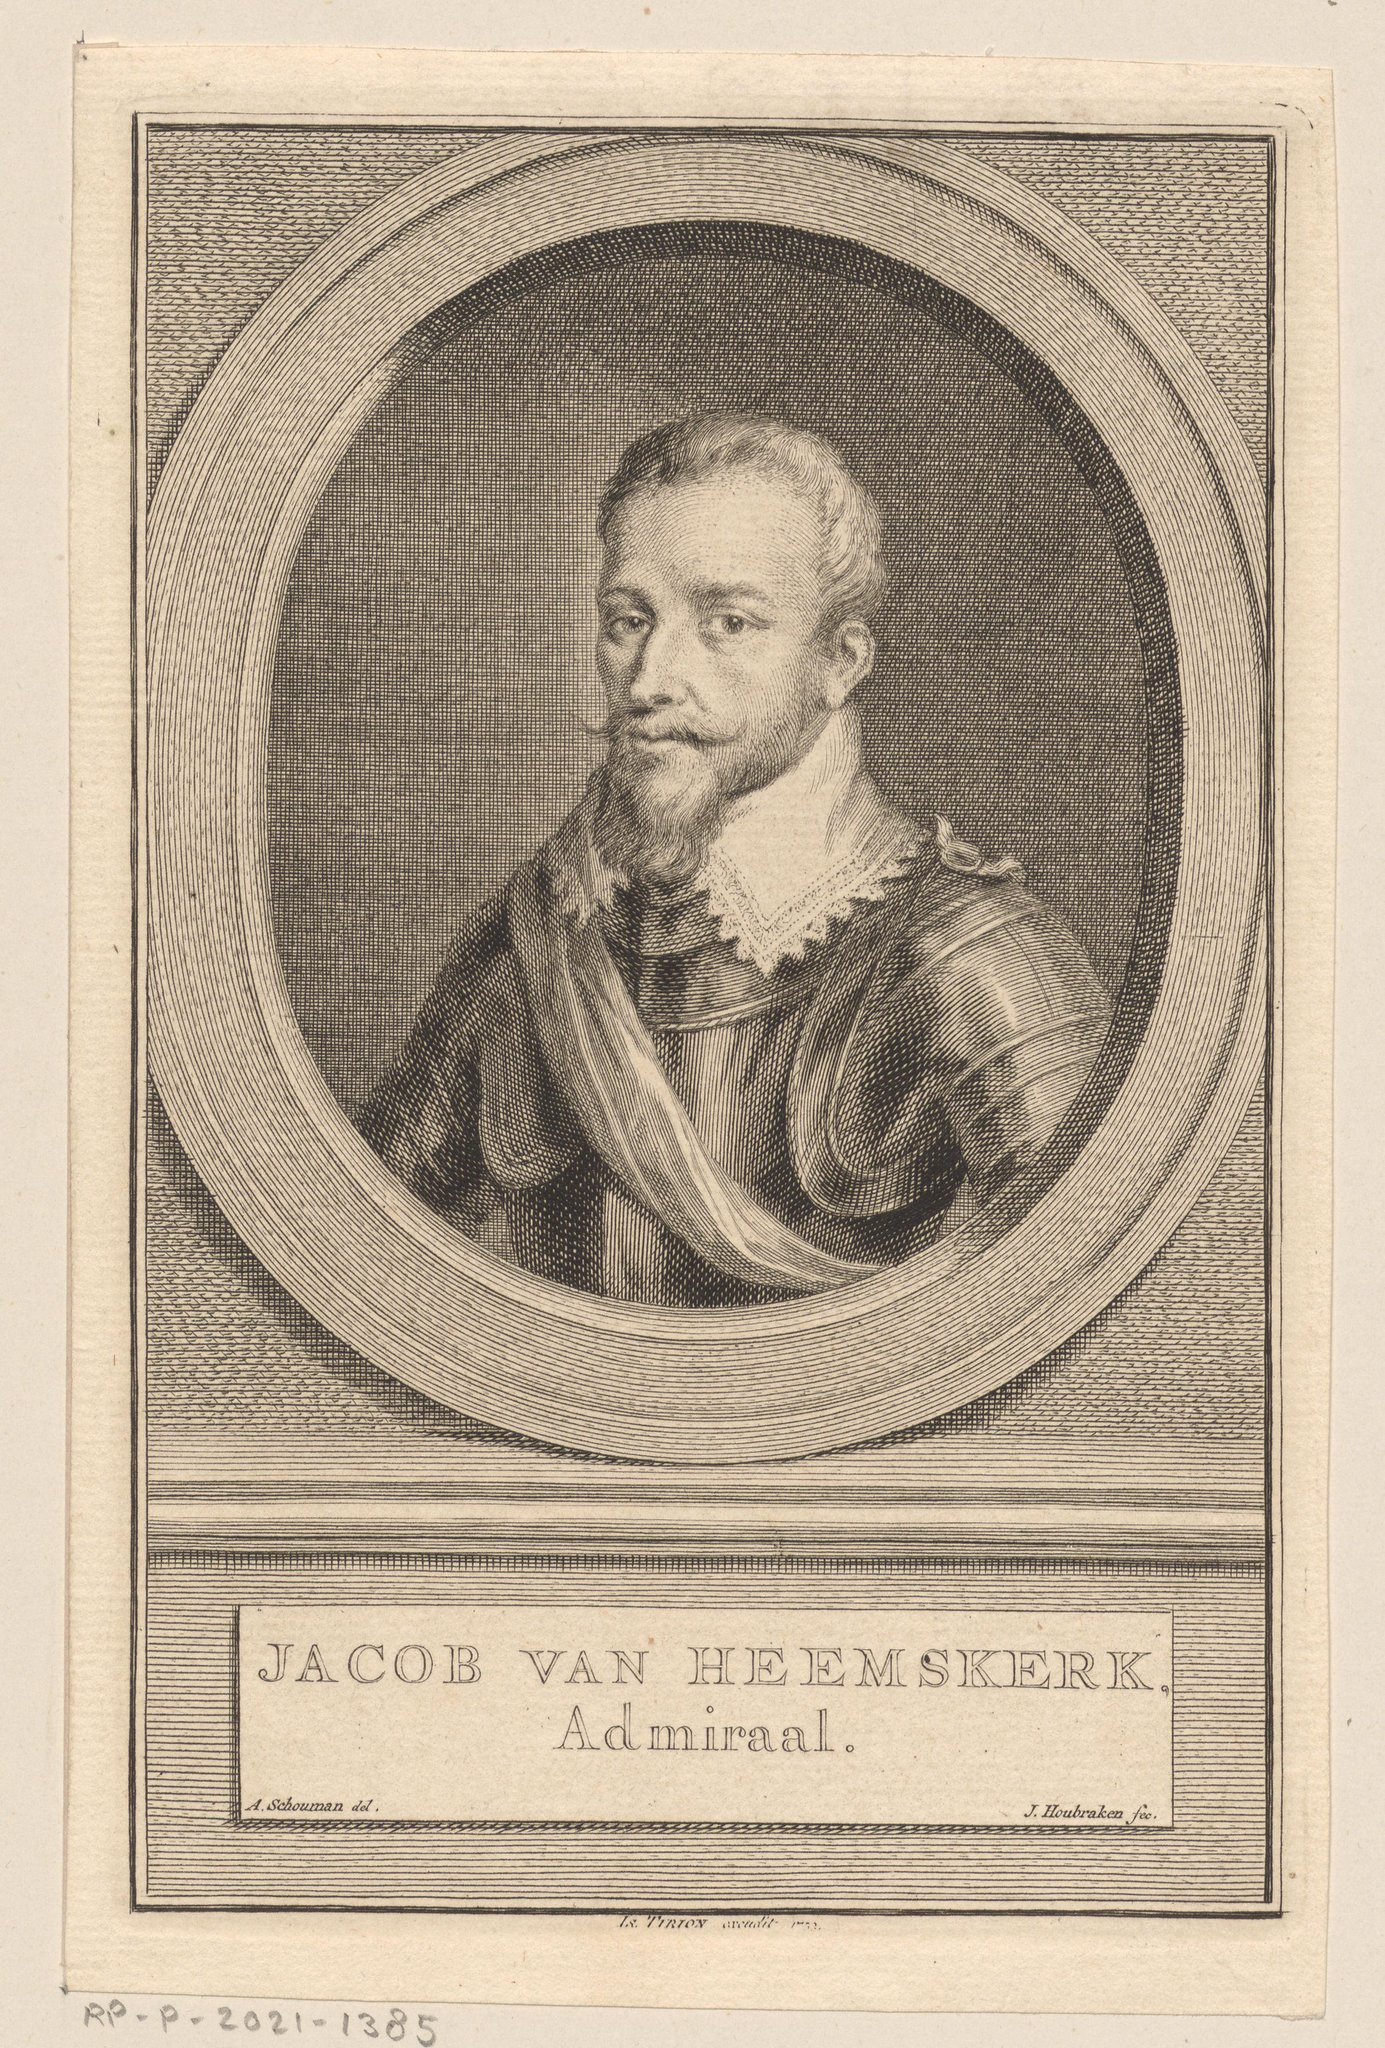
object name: print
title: Portret van Jacob van Heemskerck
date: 1753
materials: paper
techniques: engraving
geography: amsterdam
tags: jacob van heemskerck, armour, historical persons, commander-in-chief, admiral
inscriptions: date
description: Prent uit: Wagenaar, Jan. Vaderlandsche historie, vervattende de geschiedenissen der nu Vereenigde Nederlanden (...). 21 dln. Amsterdam: Isaak Tirion, 1753, dl. 9. Prent ook gebruikt in latere edities van dit werk.